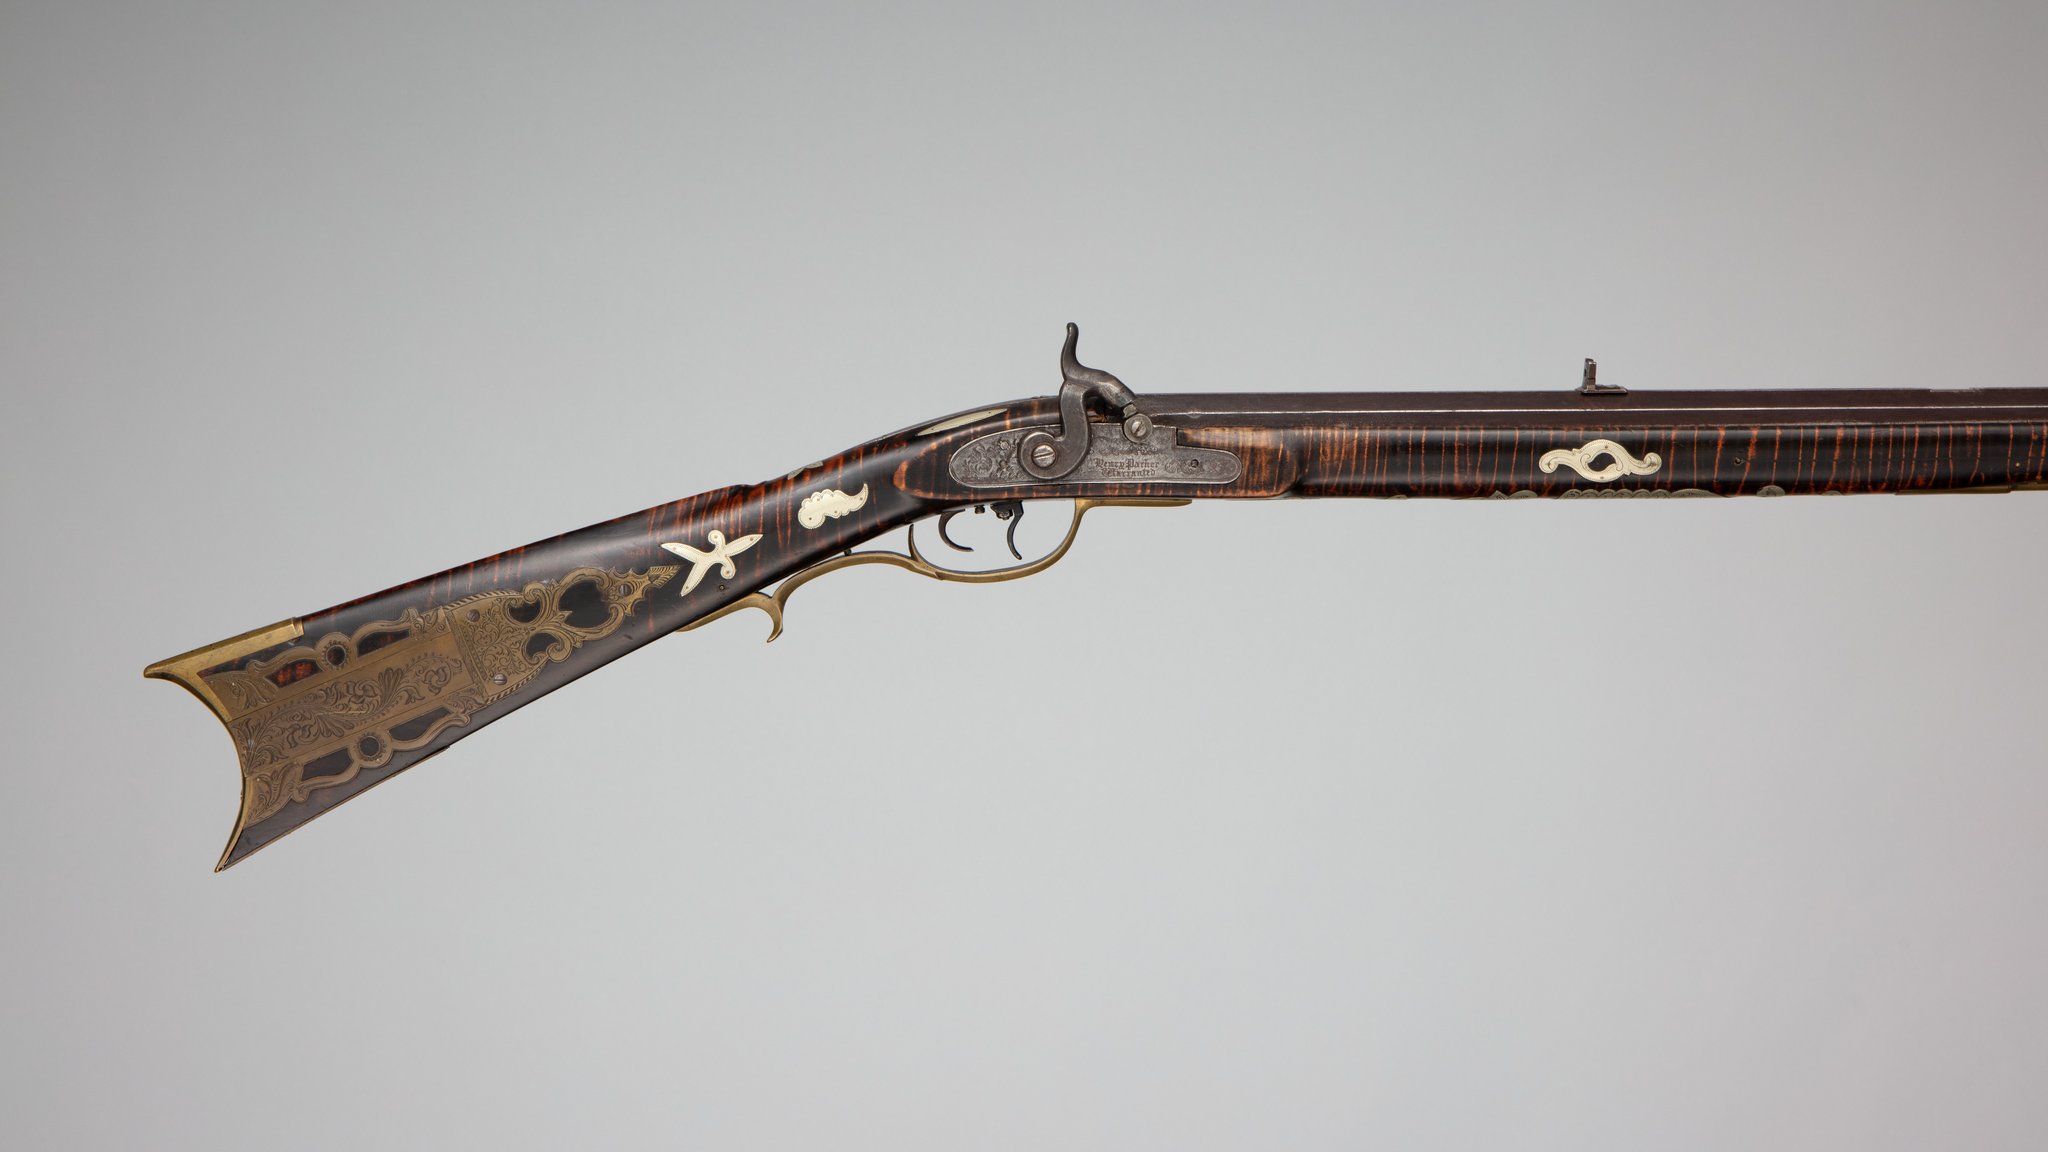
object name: percussion longrifle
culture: american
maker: joseph douglass jr.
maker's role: gunsmith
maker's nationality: american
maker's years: 1819-1880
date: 1840-1850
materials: brass, silver, steel, wood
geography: united states